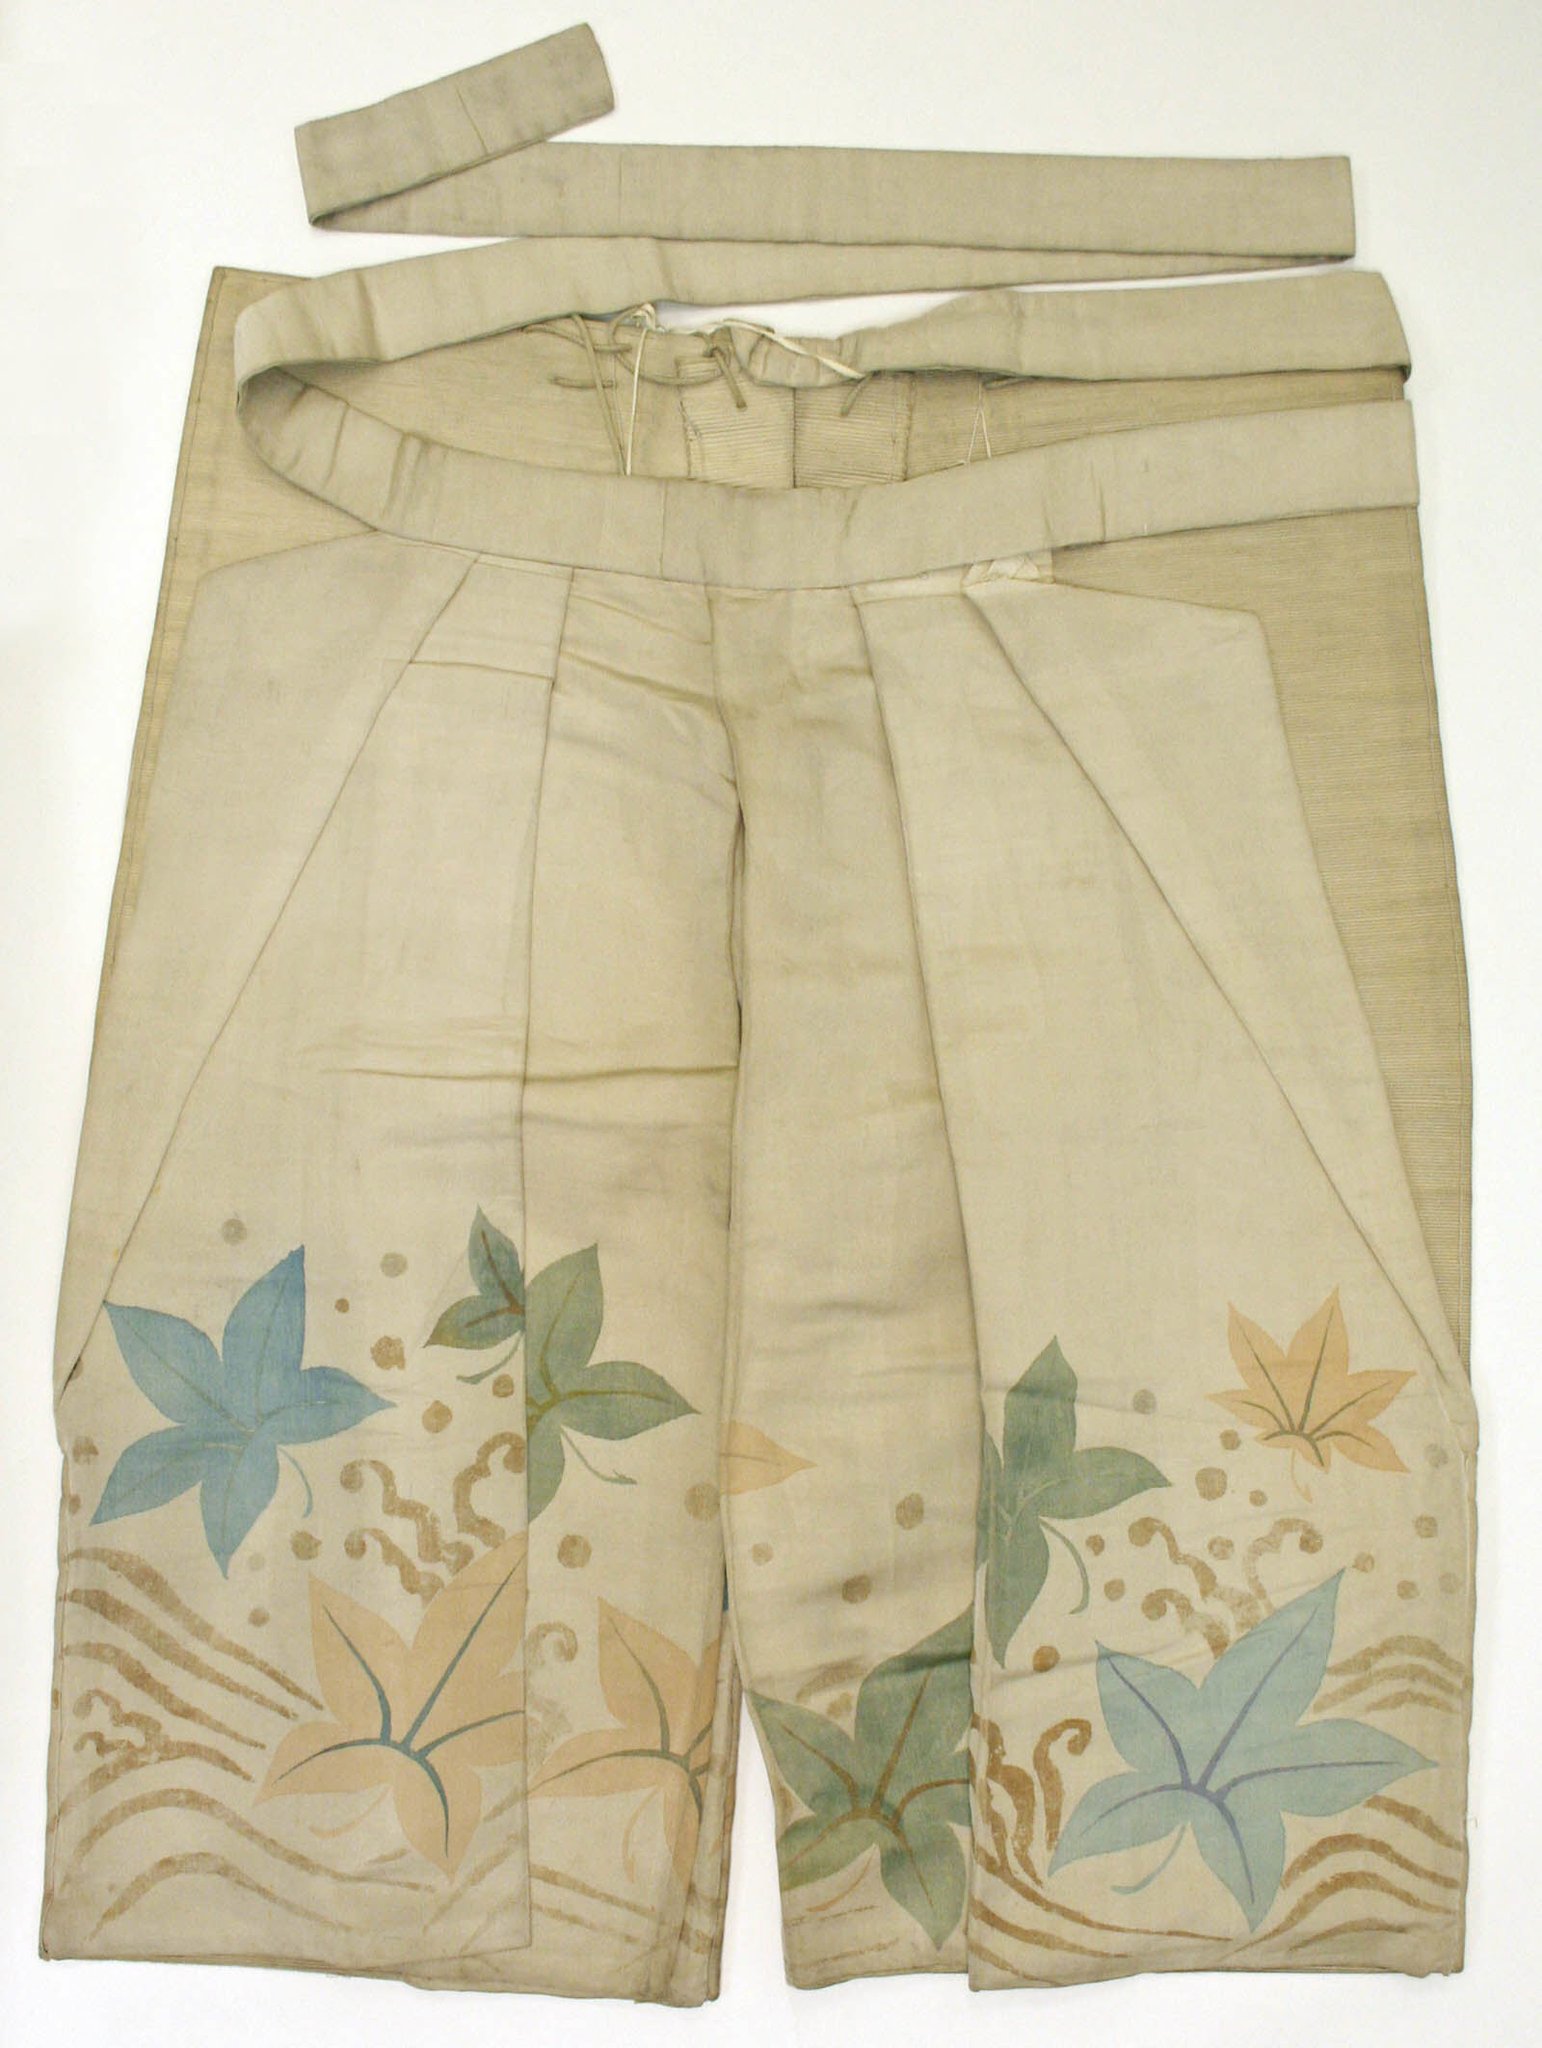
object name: theatrical costume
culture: japanese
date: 1801-1900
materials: cotton, silk